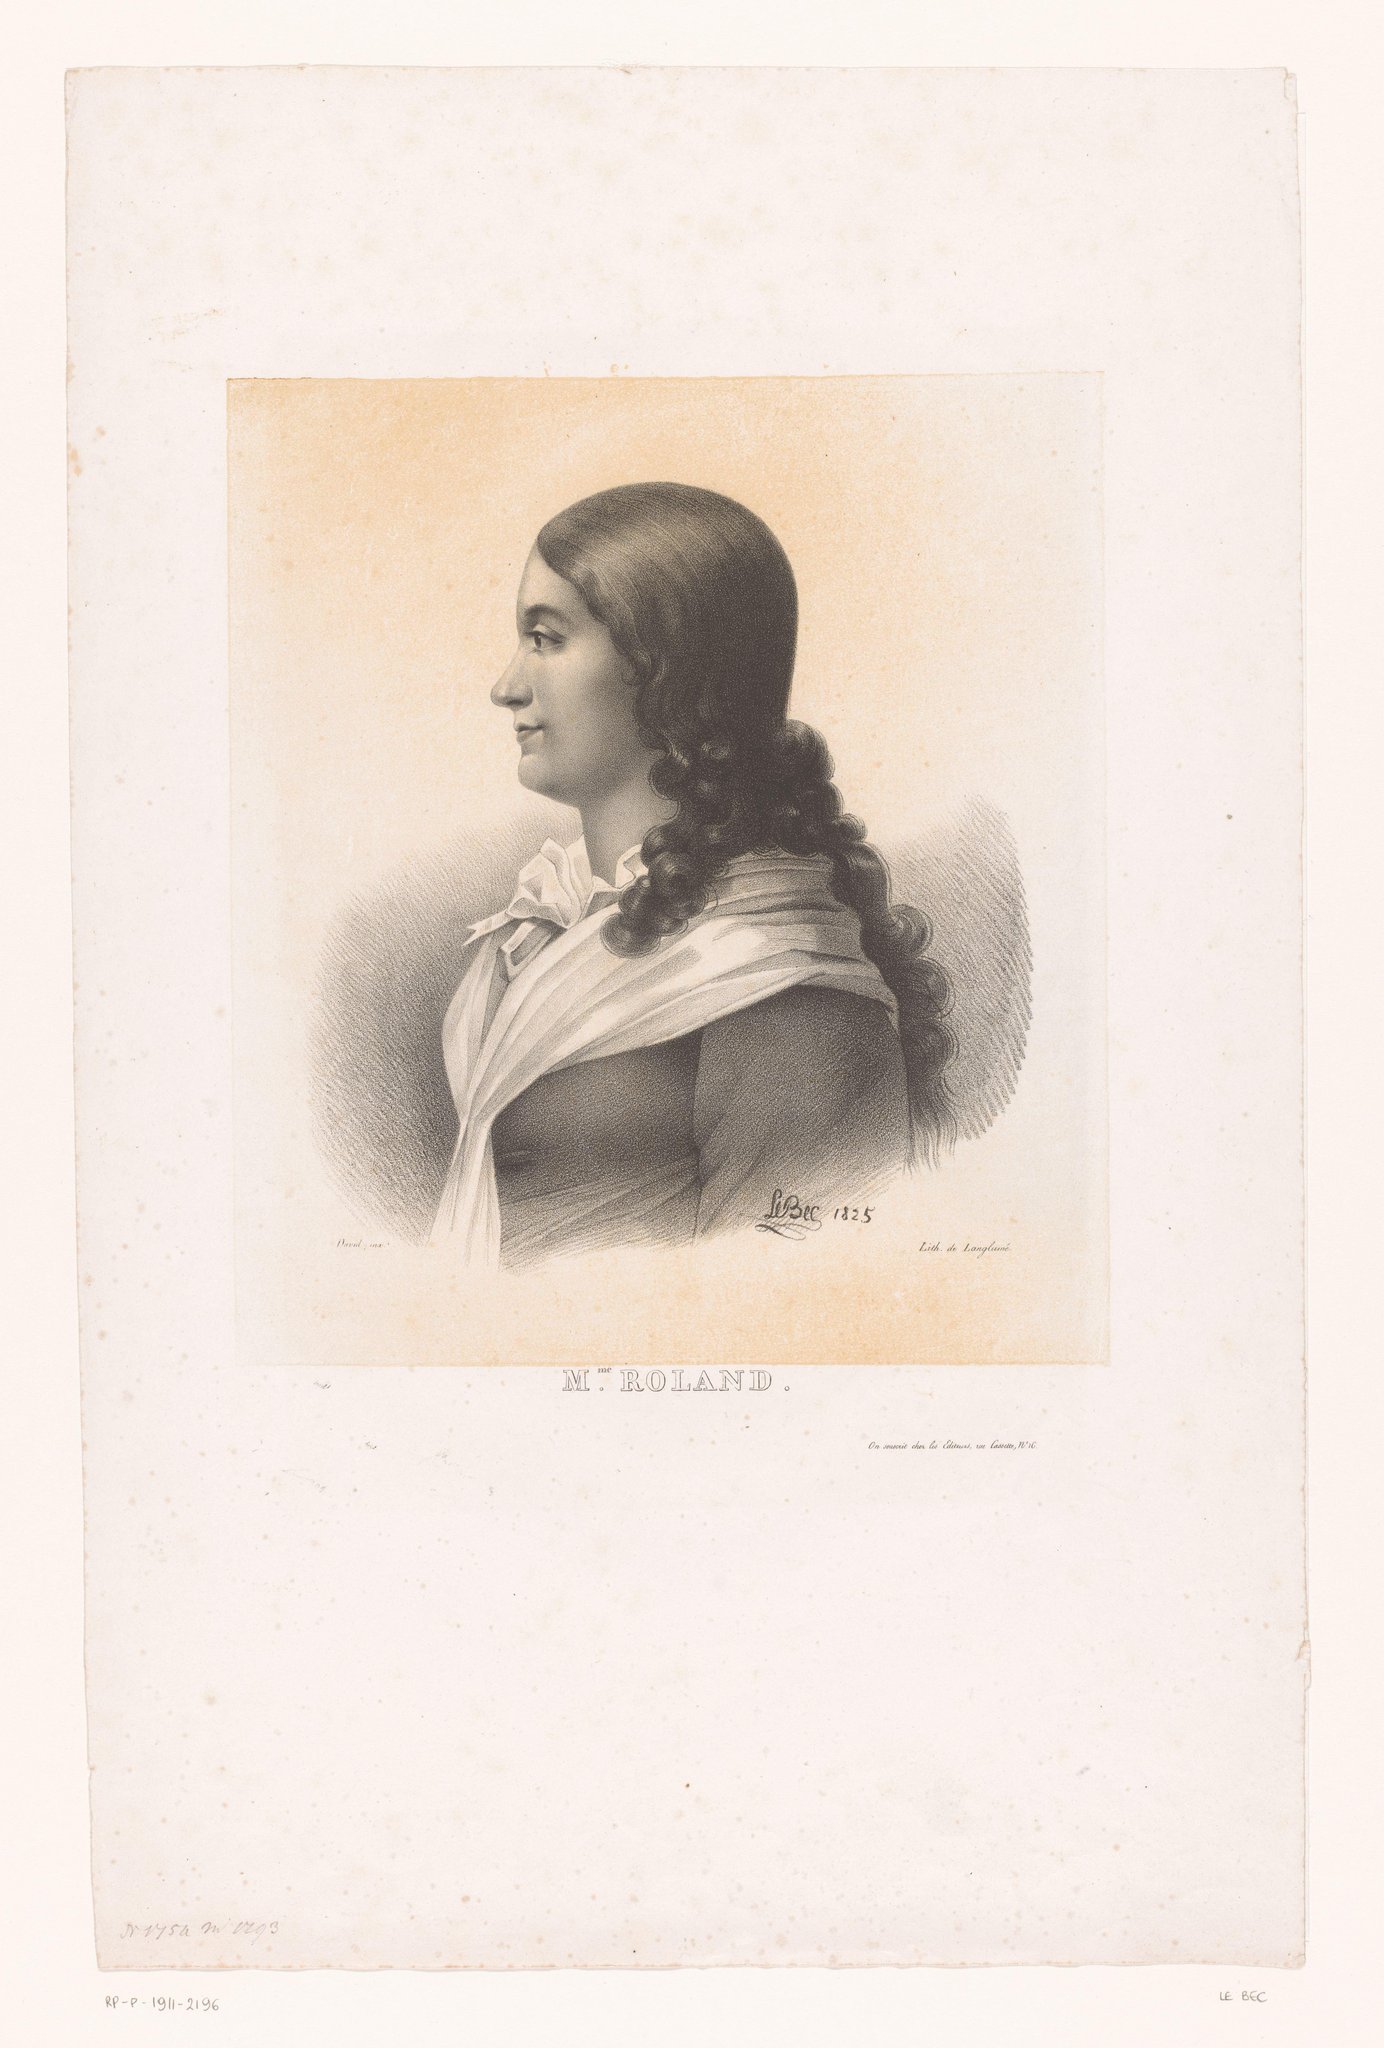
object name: print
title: Portret van Manon Roland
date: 1825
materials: paper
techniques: lithograph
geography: paris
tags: historical persons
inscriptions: collector's mark: Lugt 2228a